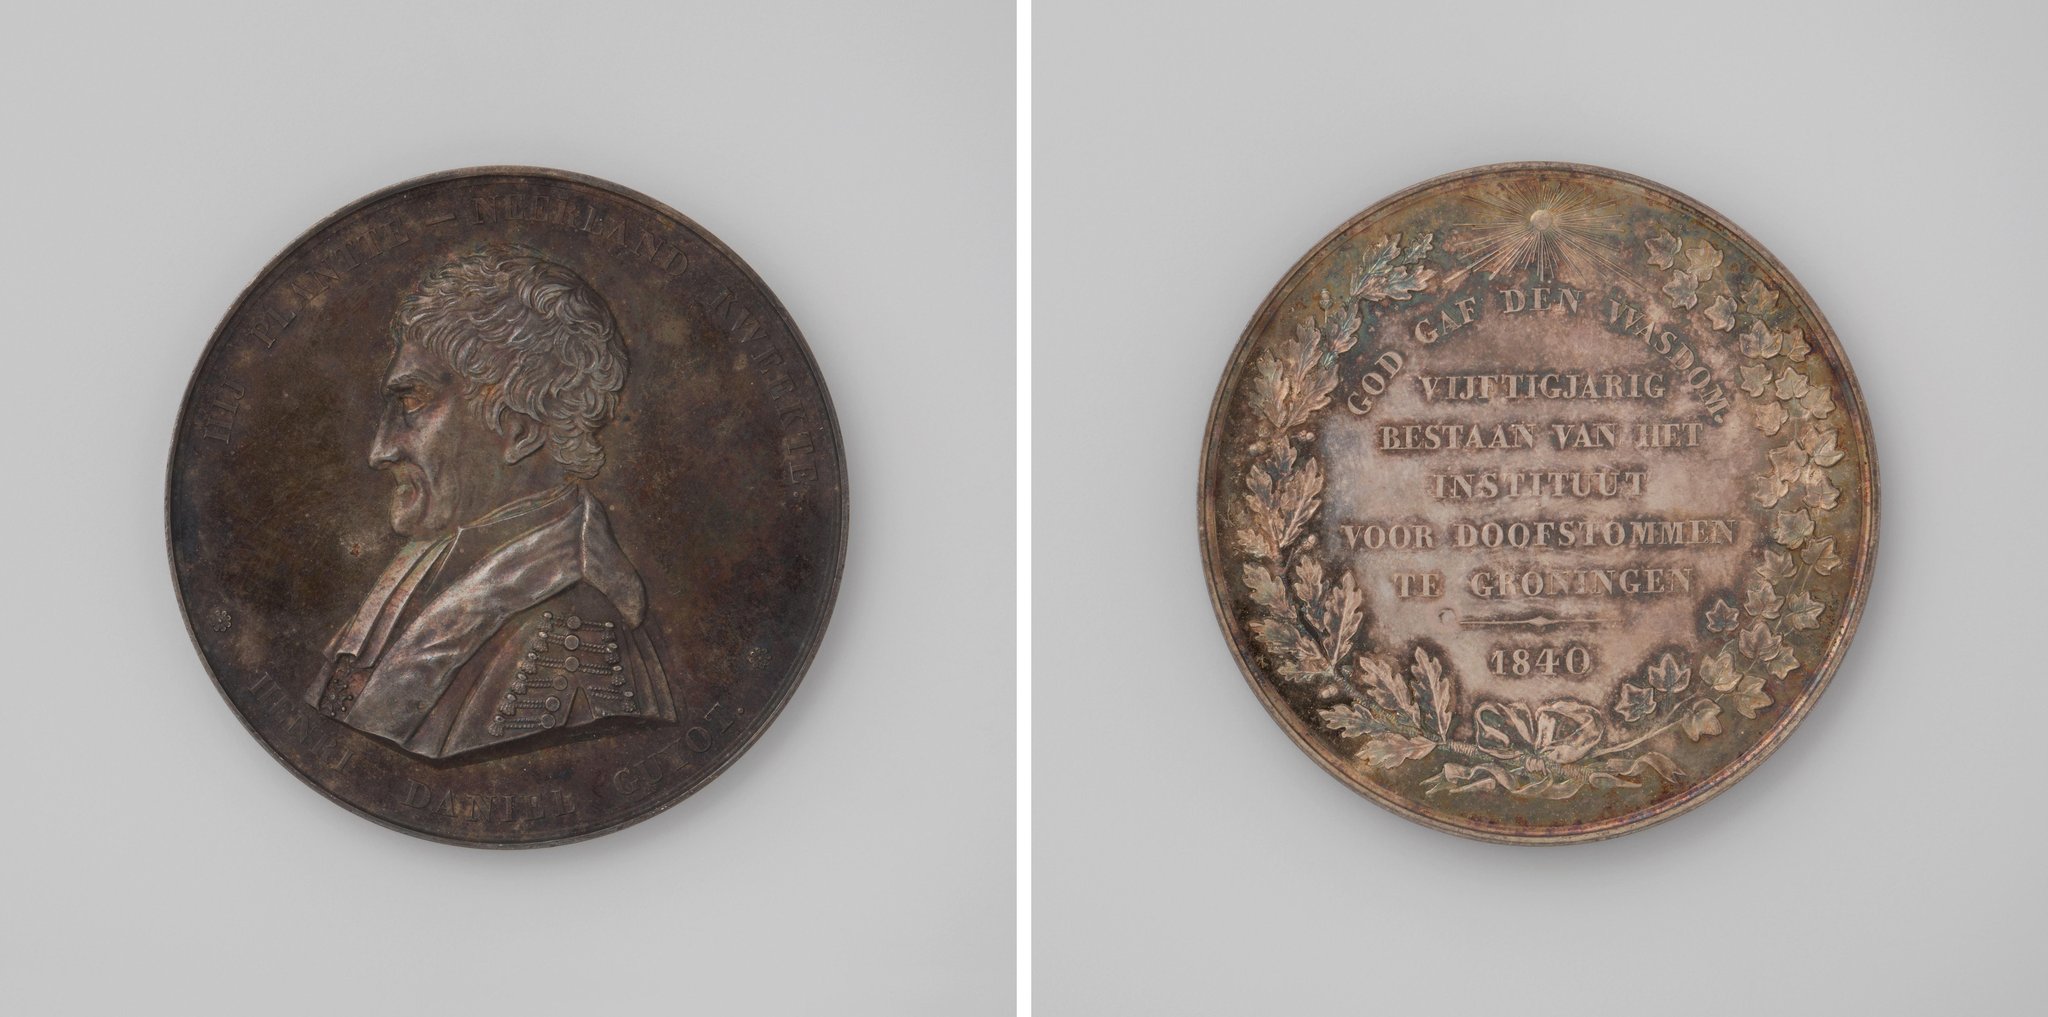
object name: history medal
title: Penning ter ere van het vijftigjarig bestaan van het door Henri Daniel Guyot opgerichte Instituut voor Doofstommen te Groningen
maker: david van der kellen (1804-1879)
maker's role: die cutter, draughtsman, print maker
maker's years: 1804-1879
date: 1840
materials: silver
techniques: striking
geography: utrecht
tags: france, deaf, deafness, specialized institutions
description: Zilveren penning. Voorzijde: borststuk man binnen omschrift. Keerzijde: opschrift binnen omschrift en tot krans samengebonden eike- en klimoptak, beschenen door hemellicht